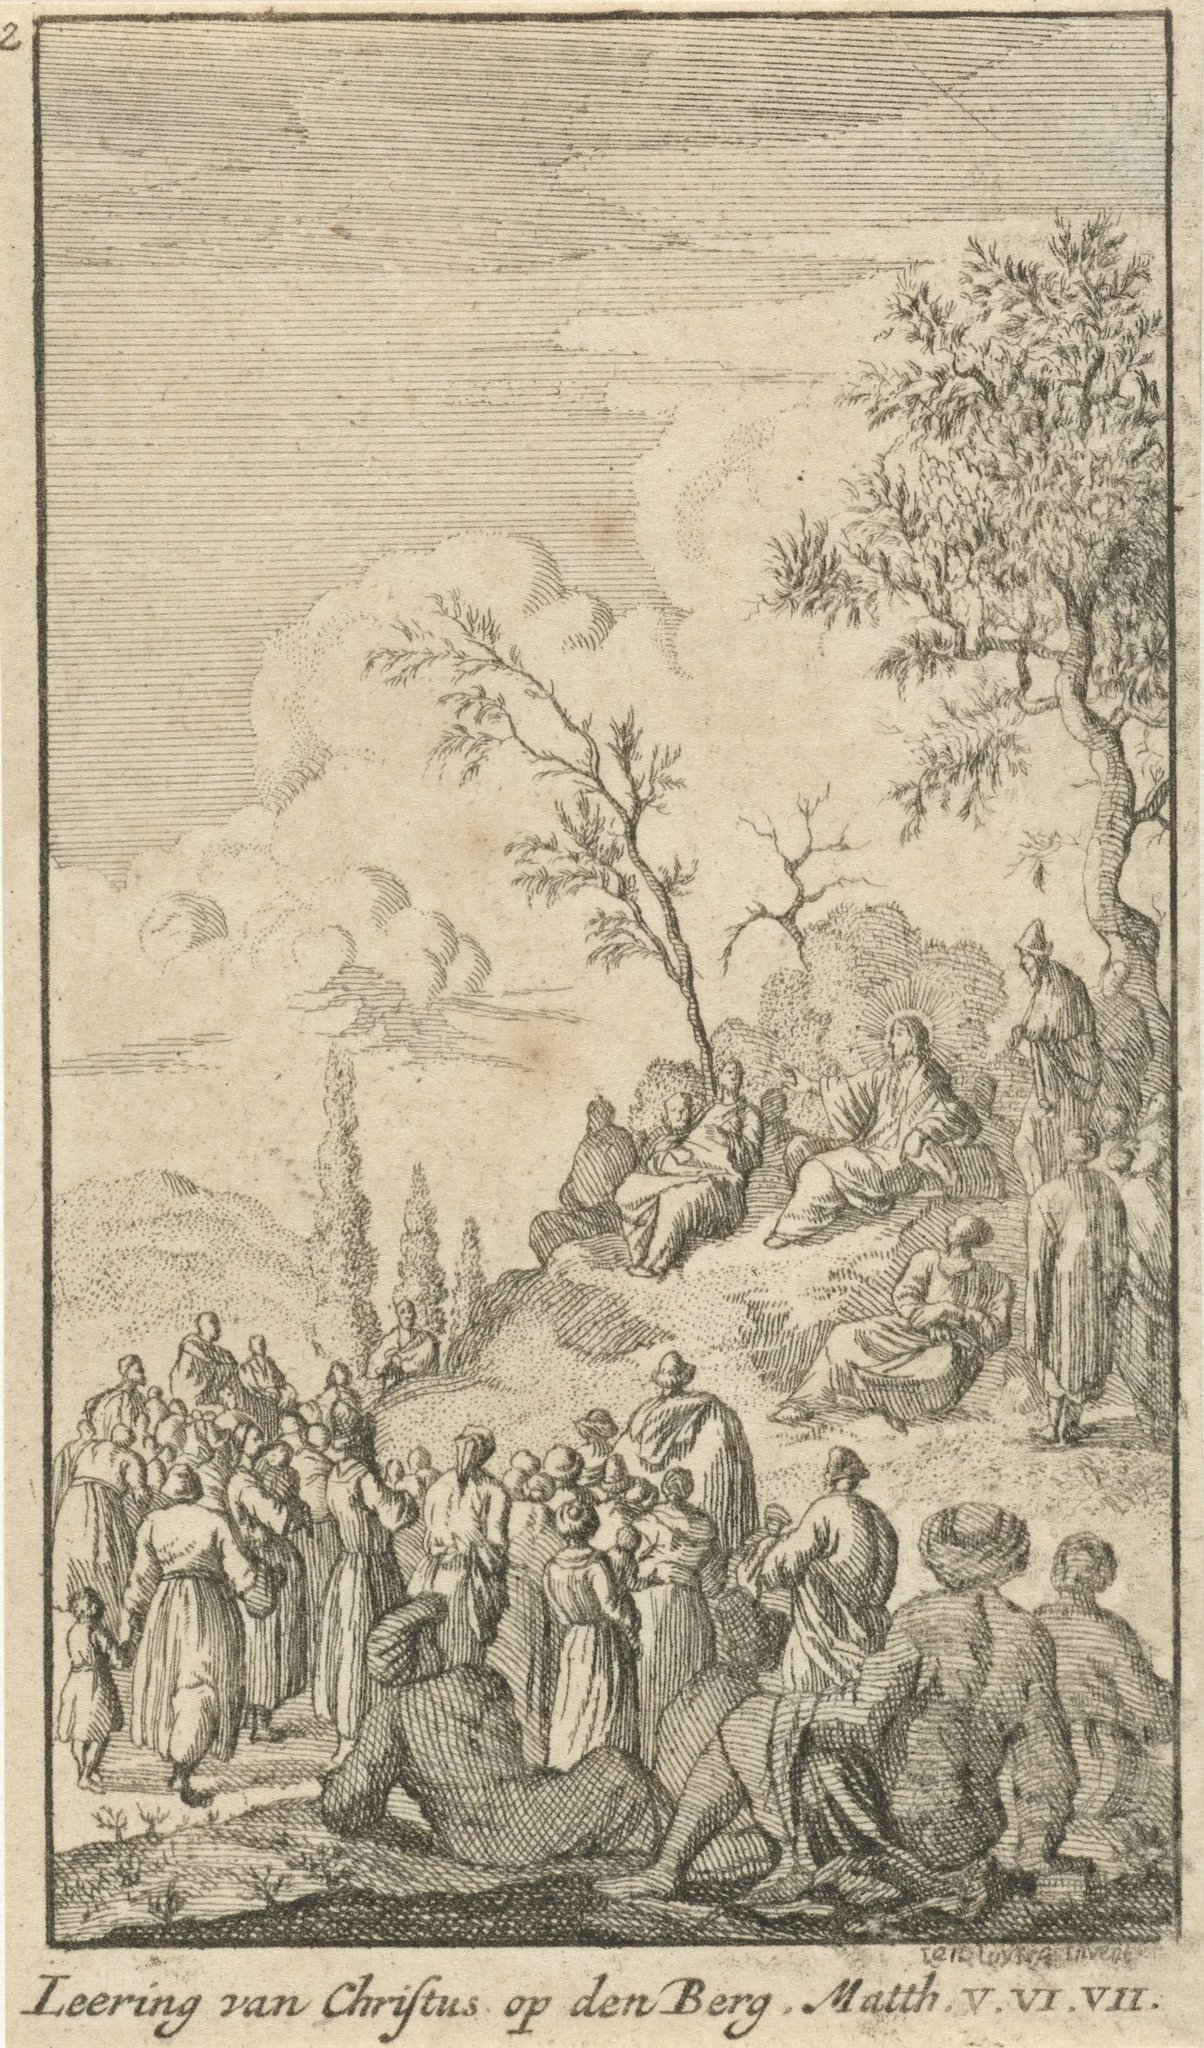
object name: book illustration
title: Leering van Christus op den Berg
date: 1720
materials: paper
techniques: etching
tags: 'command these stones to become loaves of bread' ~ temptation of christ in the wilderness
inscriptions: collector's mark: Lugt 2228, number: ‘2’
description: Prent opgenomen in: Het Nieuw Testament onzes Heere Jesus Christus. Amsterdam: Wed. Albert Klumper en Jan Kalverum, 1720. In dit boek is de gehele serie met 24 scènes uit het Nieuwe Testament naar Jan Luyken opgenomen. De originele prent door J. Luyken verscheen mogelijk voor het eerst in: Het Nieuwe Testament ofte alle Boecken des Nieuwen Verbondts onses Heeren Iesu Christi. Amsterdam: Hieronymus Sweerts, Jan ten Hoorn, Jan Bouman en Daniel van den Dalen, 1681.